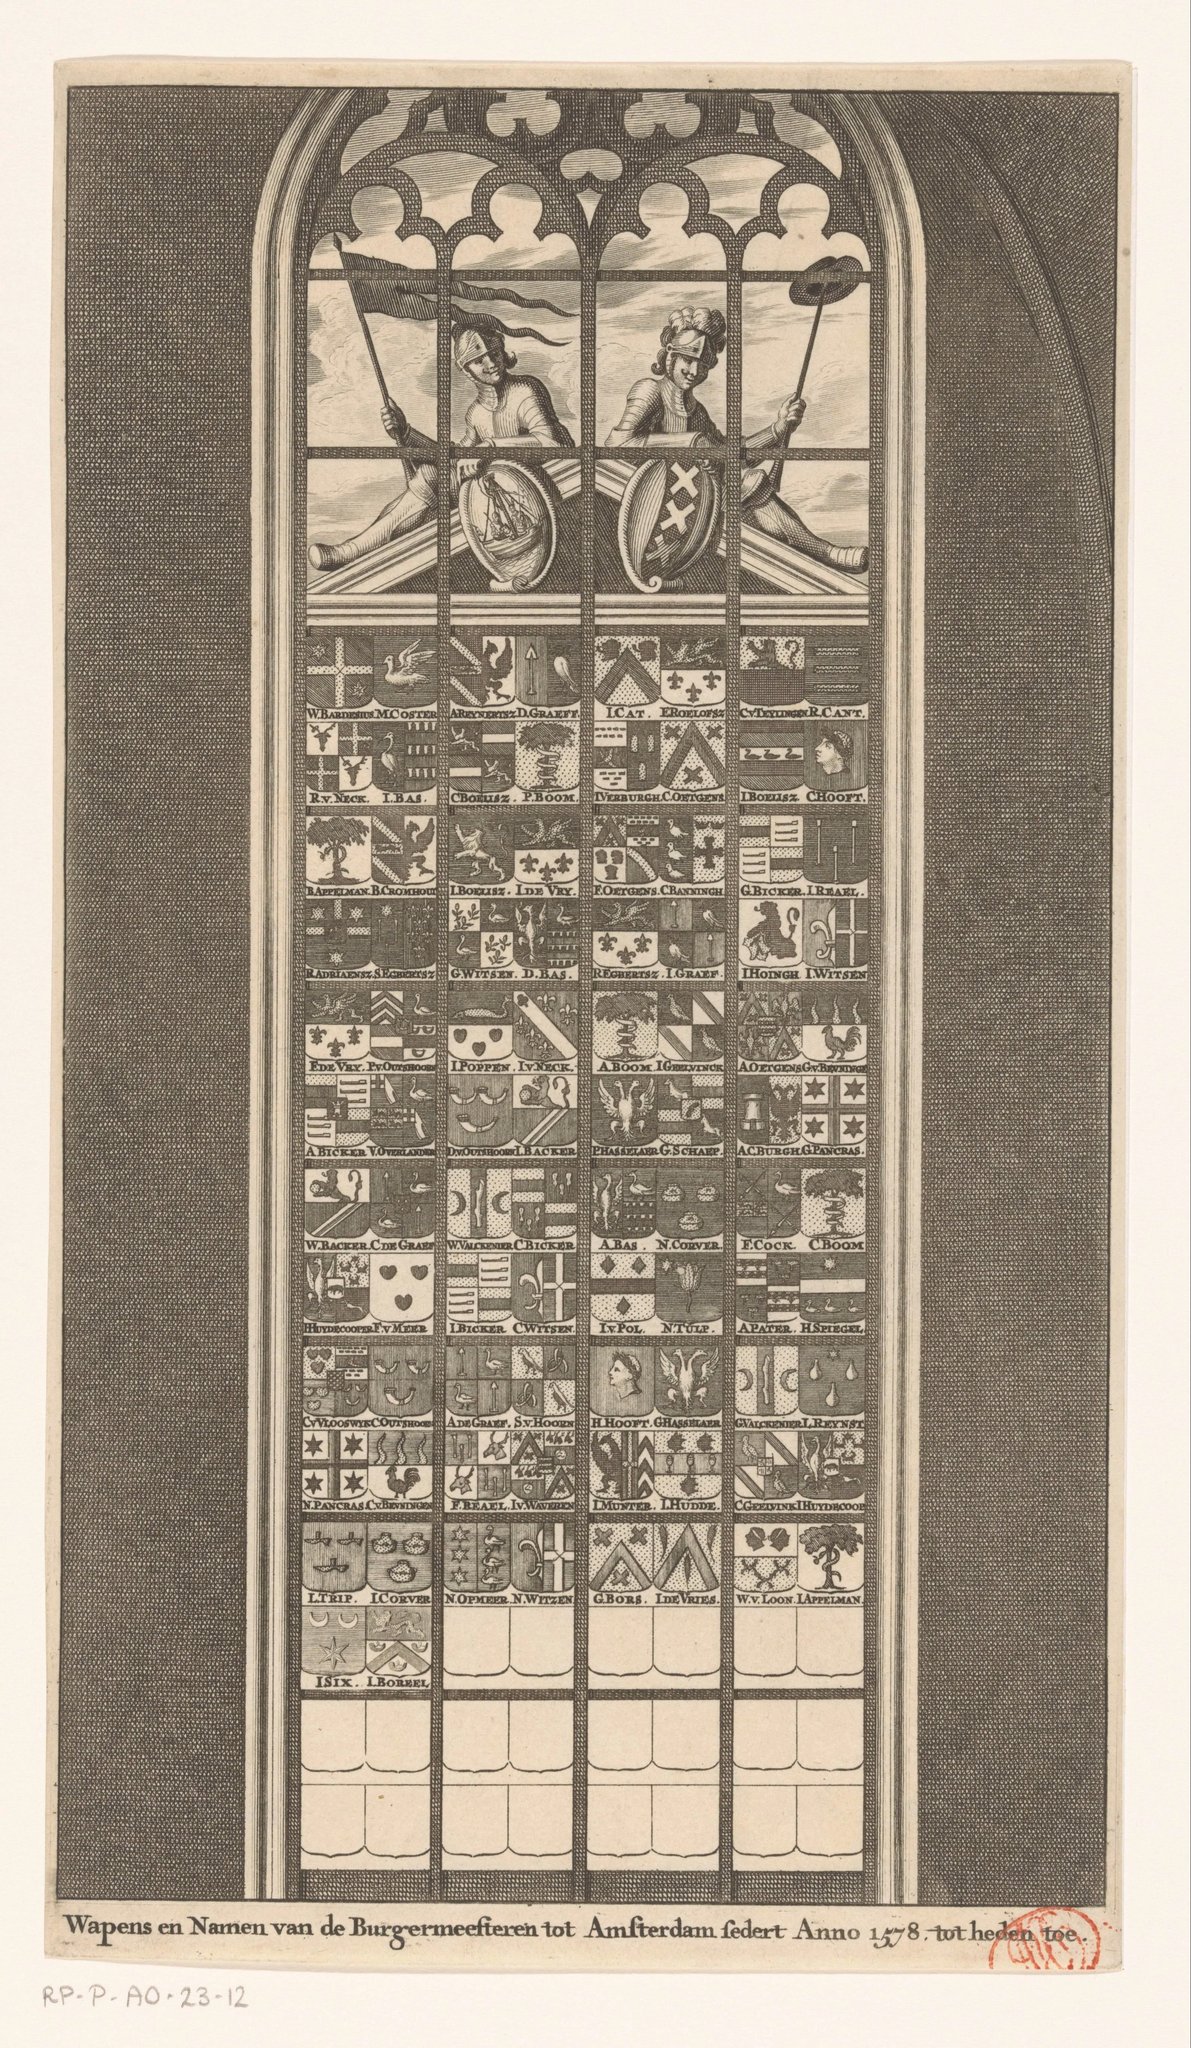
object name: print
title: Wapens en Namen van de Burgermeesteren tot Amsterdam sedert Anno 1578, tot heden toe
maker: Anonymous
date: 1693-1726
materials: paper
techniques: engraving, etching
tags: coat of arms (as symbol of the state, etc.) (+ city; municipal), seal (as symbol of the state, etc.) (+ city; municipal), church-window, e.g. rose-window, armorial bearing, heraldry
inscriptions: collector's mark: Lugt 195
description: Prent ook gebruikt in: Commelin, Caspar. Beschryvinge van Amsterdam, desselfs eerste oorspronk uyt den Huyse (…). 2 delen. Amsterdam: Abraham Wolfgang, Gillis Janssonius van Waesberge, Johannes Janssonius van Waesberge II, weduwe Dirk Boom I, Hendrick Boom en Rembertus Goethals, 1693. En in: Commelin, Caspar. Beschryvinge van Amsterdam, zynde een naukeurige verhandelinge van desselfs eerste oorspronk uyt (…). 2 delen. Amsterdam: weduwe Aart Dircksz Oossaan, 1694. En in: Commelin, Caspar. Beschryvinge van Amsterdam, zynde een naukeurige verhandelinge van desselfs eerste oorspronk uyt (…). 2 delen. 2e druk. Amsterdam: Andries van Damme, Johannes Ratelband, weduwe A. van Aaltwyk en Hermanus Uytwerf, 1726. Deze prent is ook ingebonden in enkele exemplaren van: Wagenaar, Jan. Amsterdam, in zyne opkomst, aanwas, geschiedenissen (…). 3 delen [folio-uitgave]. Amsterdam: Isaak Tirion en Yntema & Tieboel, 1760-1767, dl. 2 (Isaak Tirion, 1765). Komt echter niet voor in de lijst met in te binden prenten van deze uitgave (te vinden in dl. 3) - en is er dus ook niet voor bedoeld.